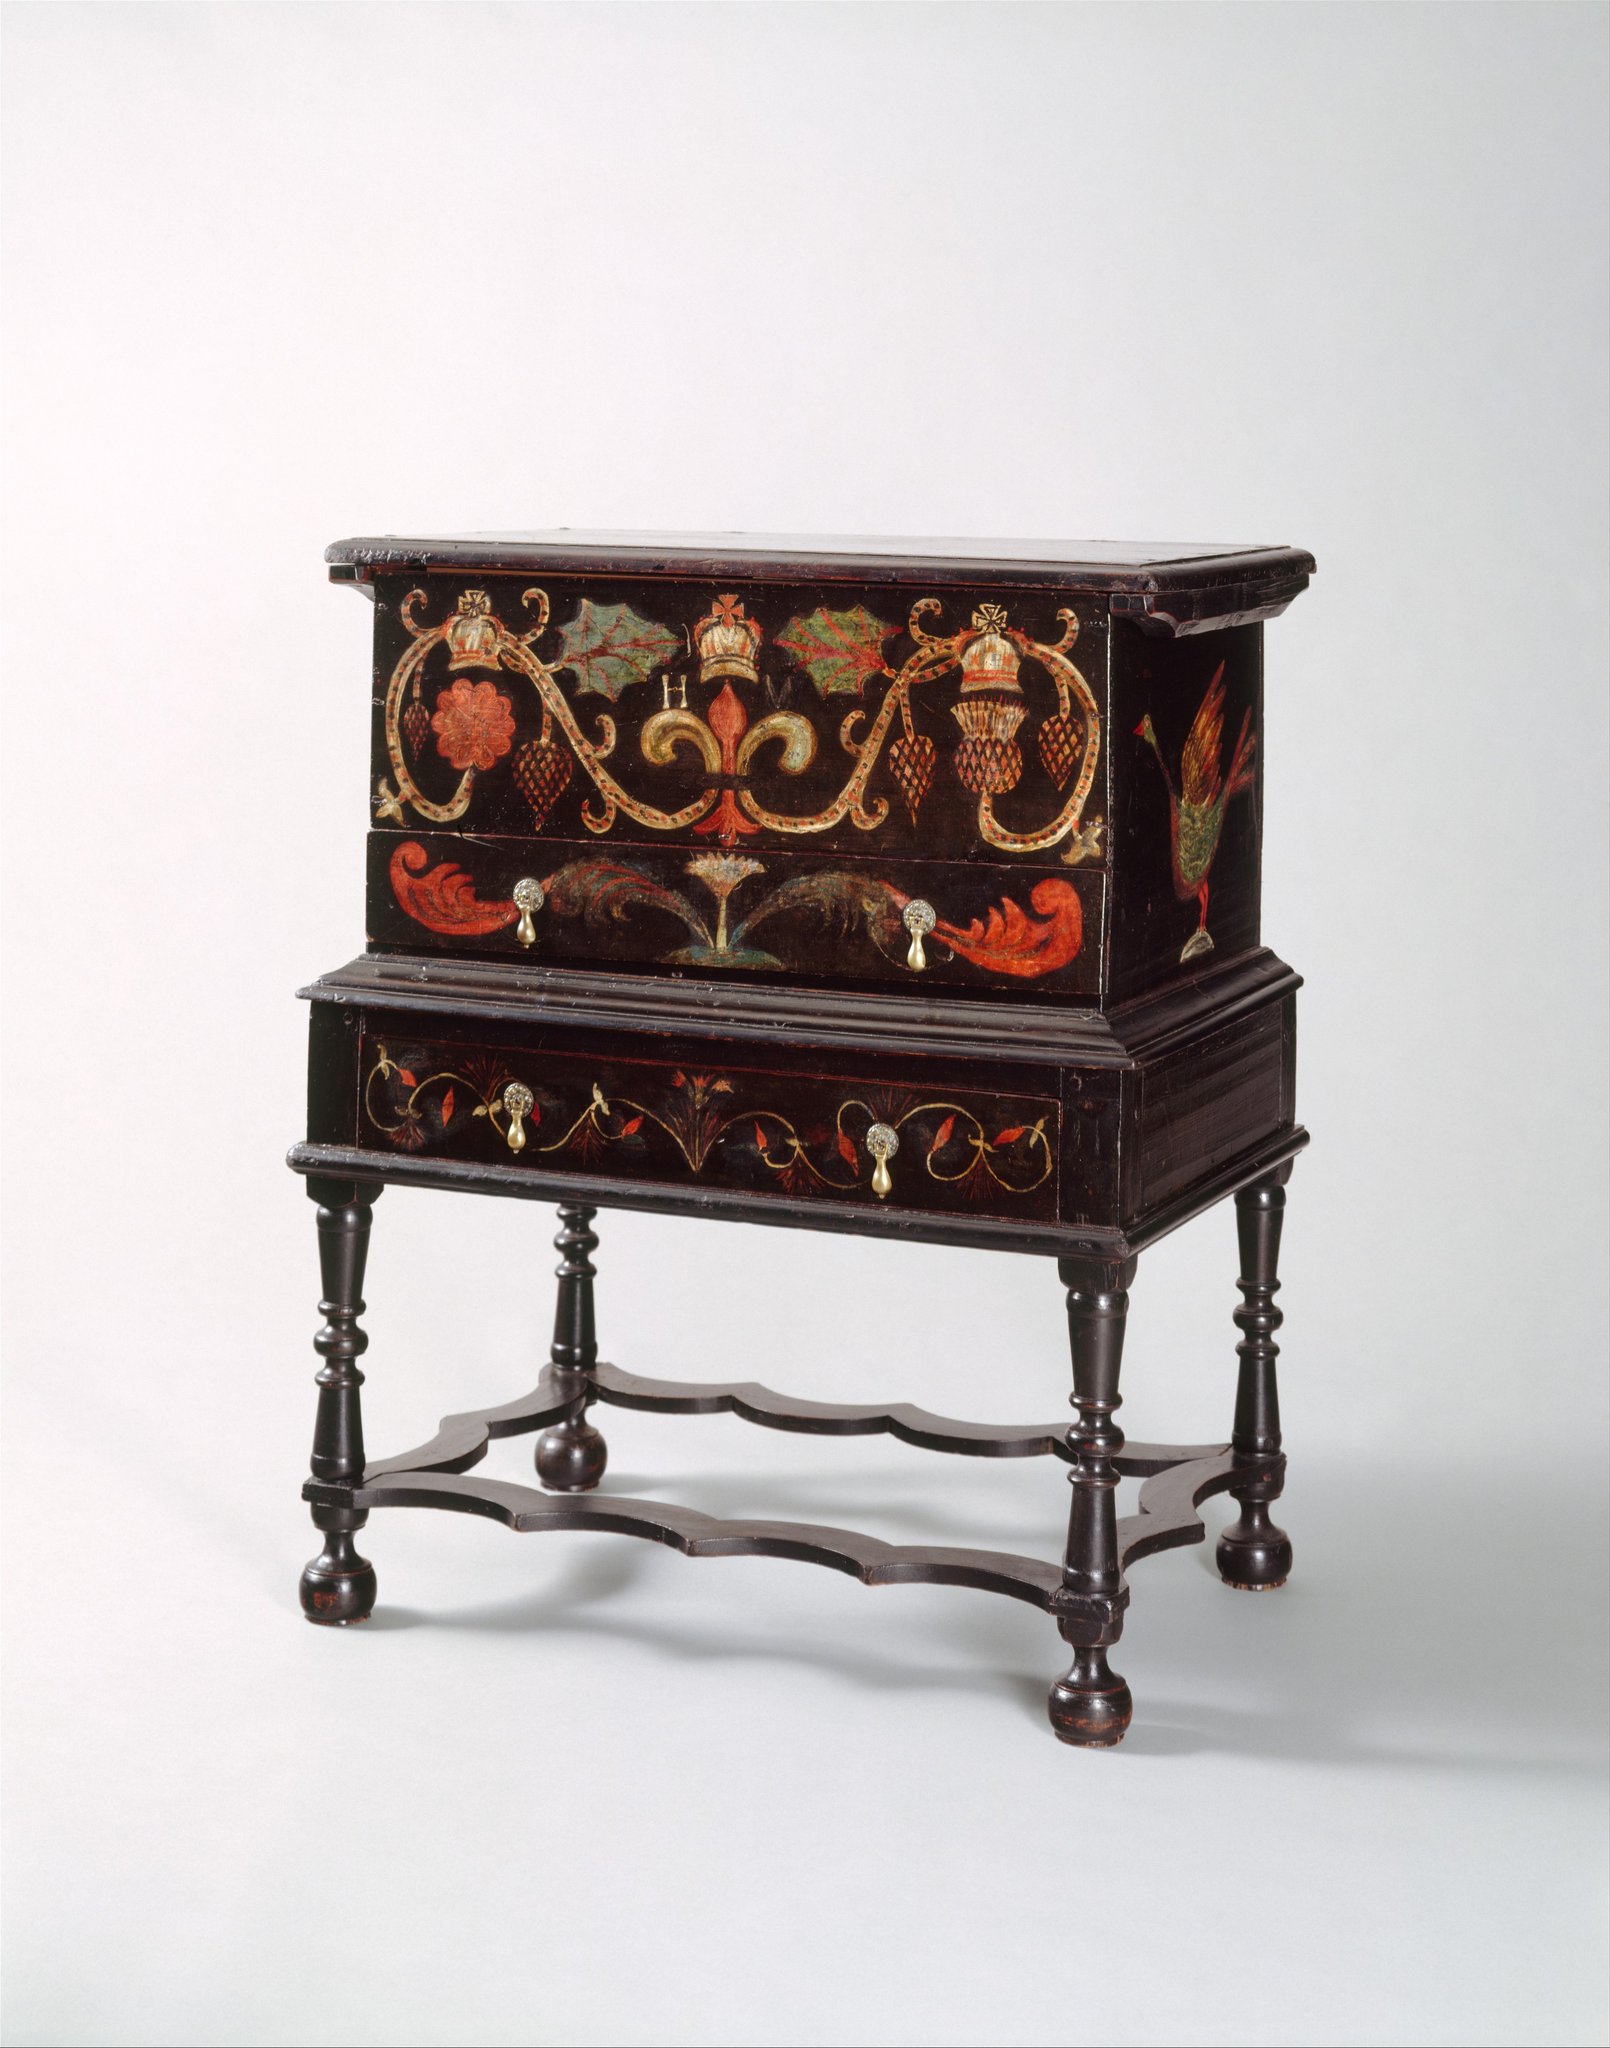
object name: chest on frame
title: Chest-on-frame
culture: american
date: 1705-1725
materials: wood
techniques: painting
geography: united states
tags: birds,flowers